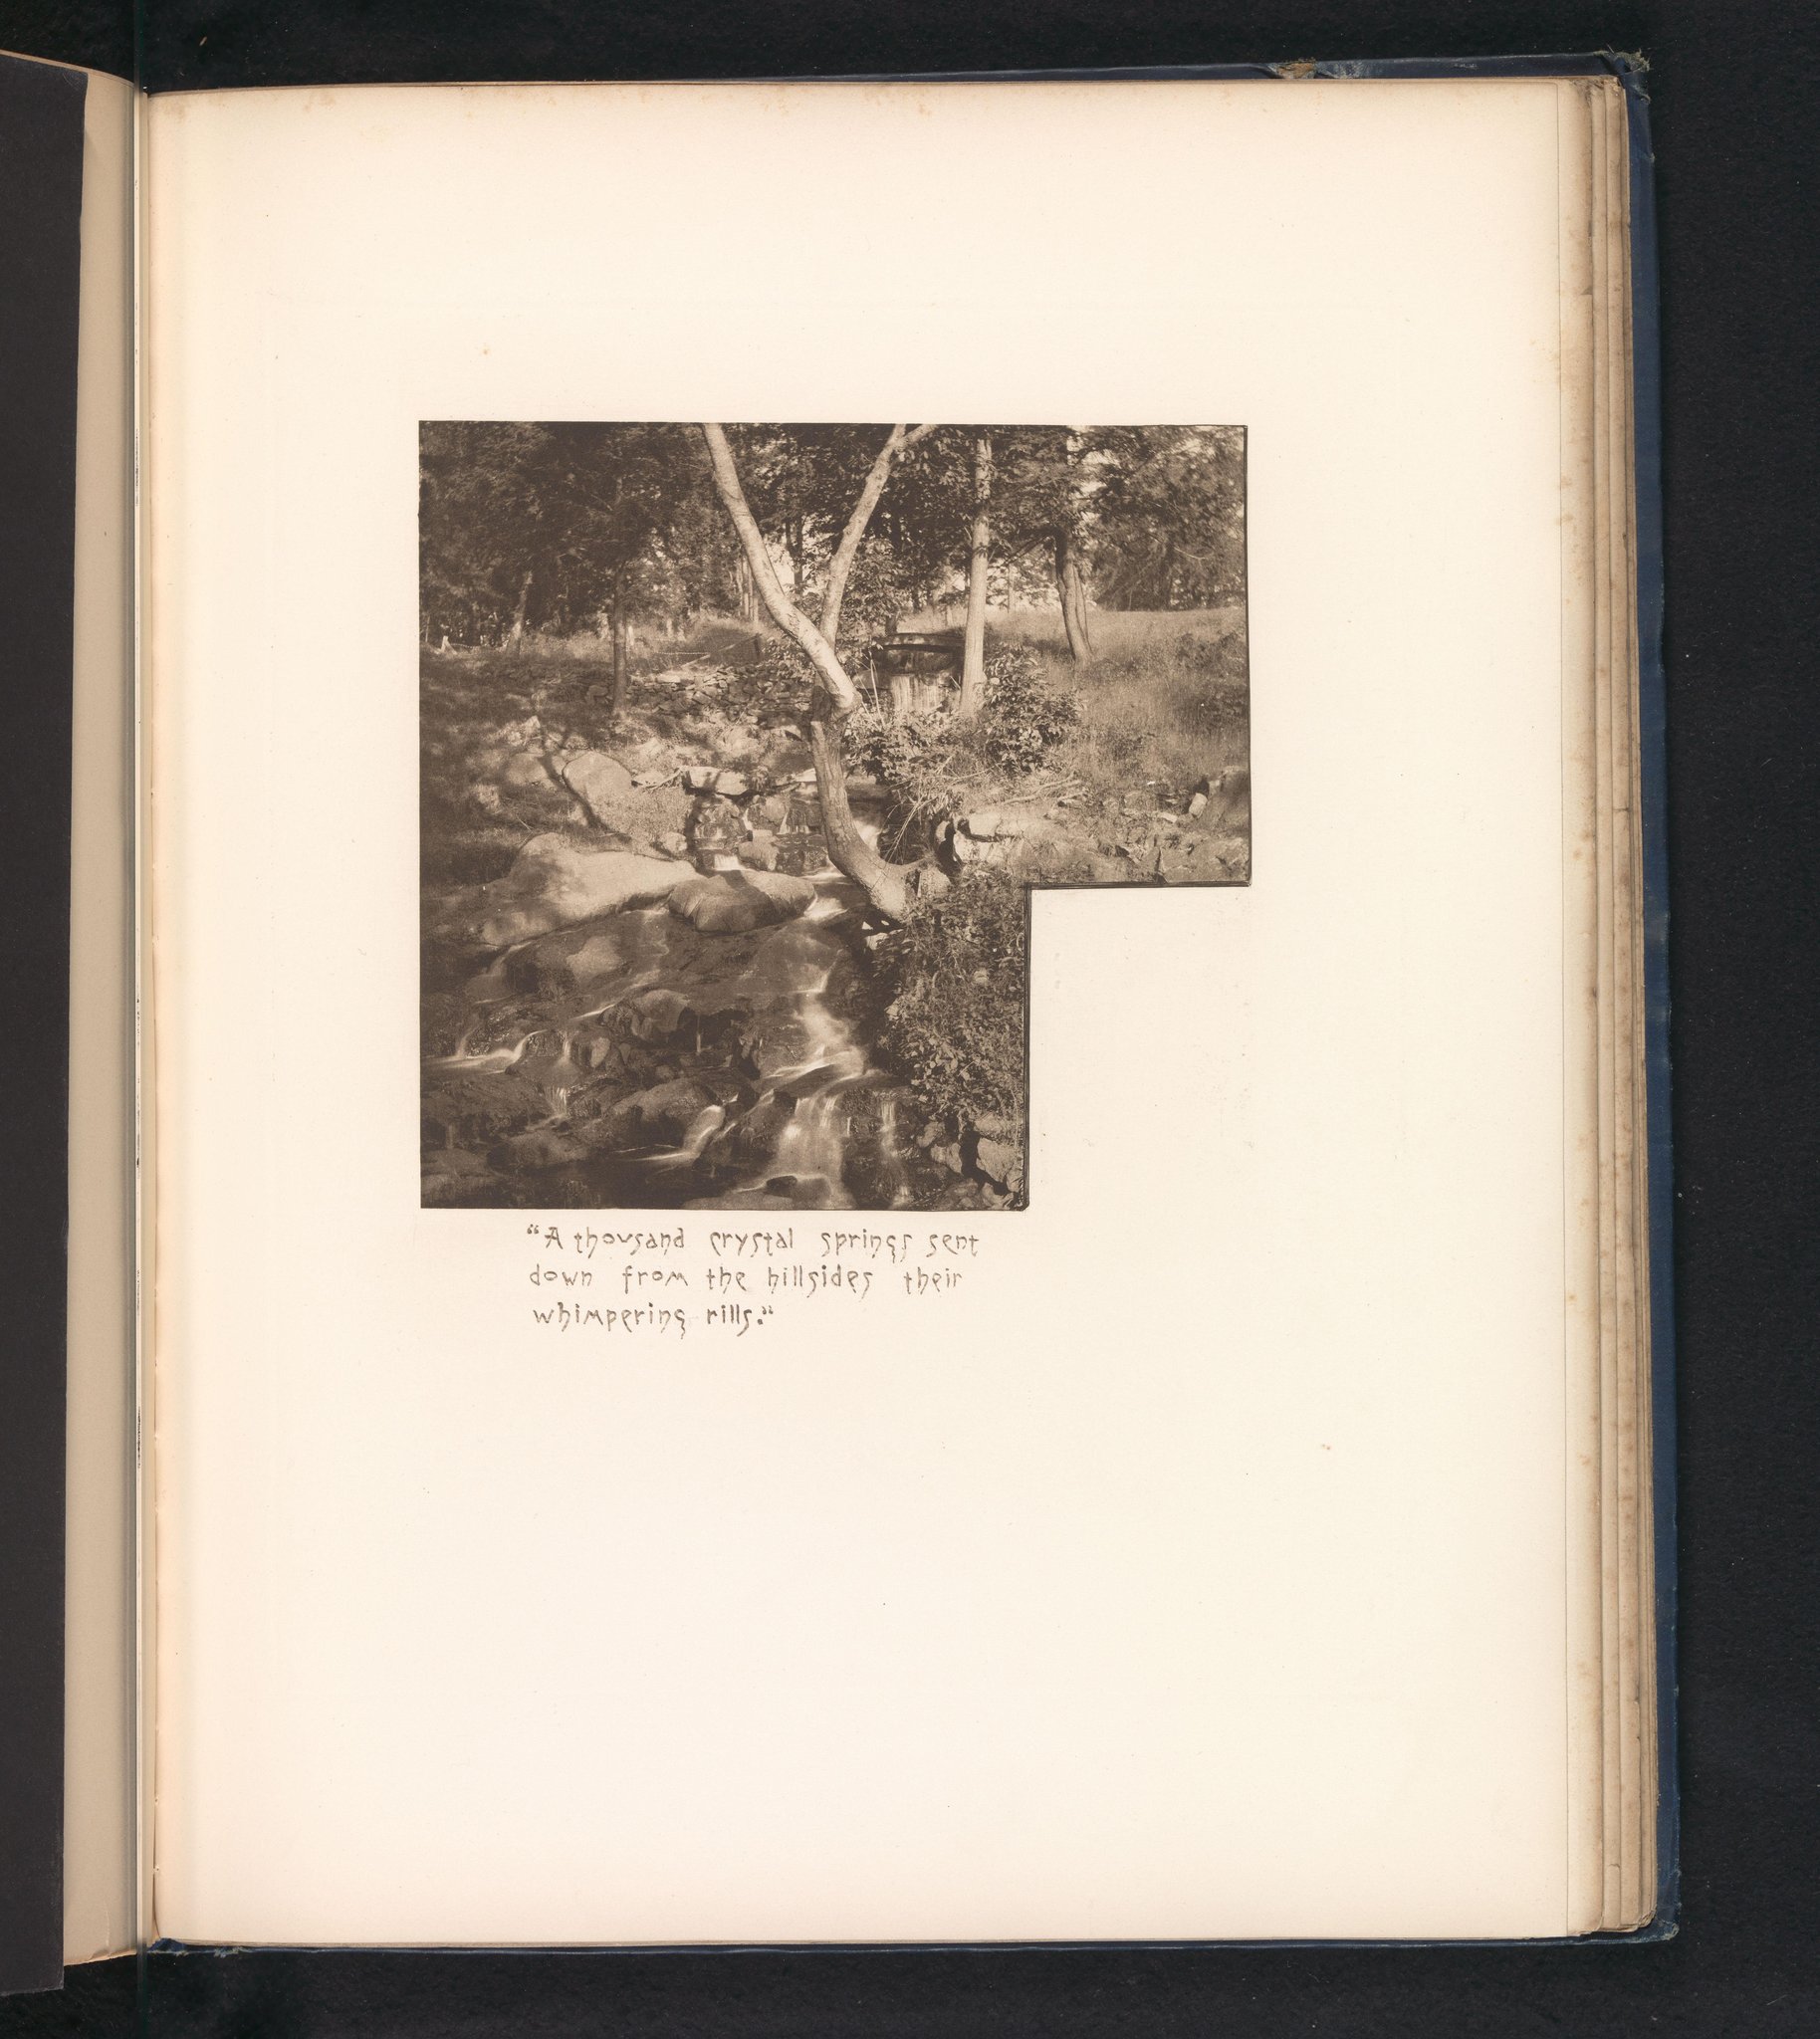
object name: page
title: Gezicht op een beek nabij Sleepy Hollow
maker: james leon williams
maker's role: fotograaf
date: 1882-1887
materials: paper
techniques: photoaquatint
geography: new york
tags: brook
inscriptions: inscription: ‘"A thousand (...) rills"’